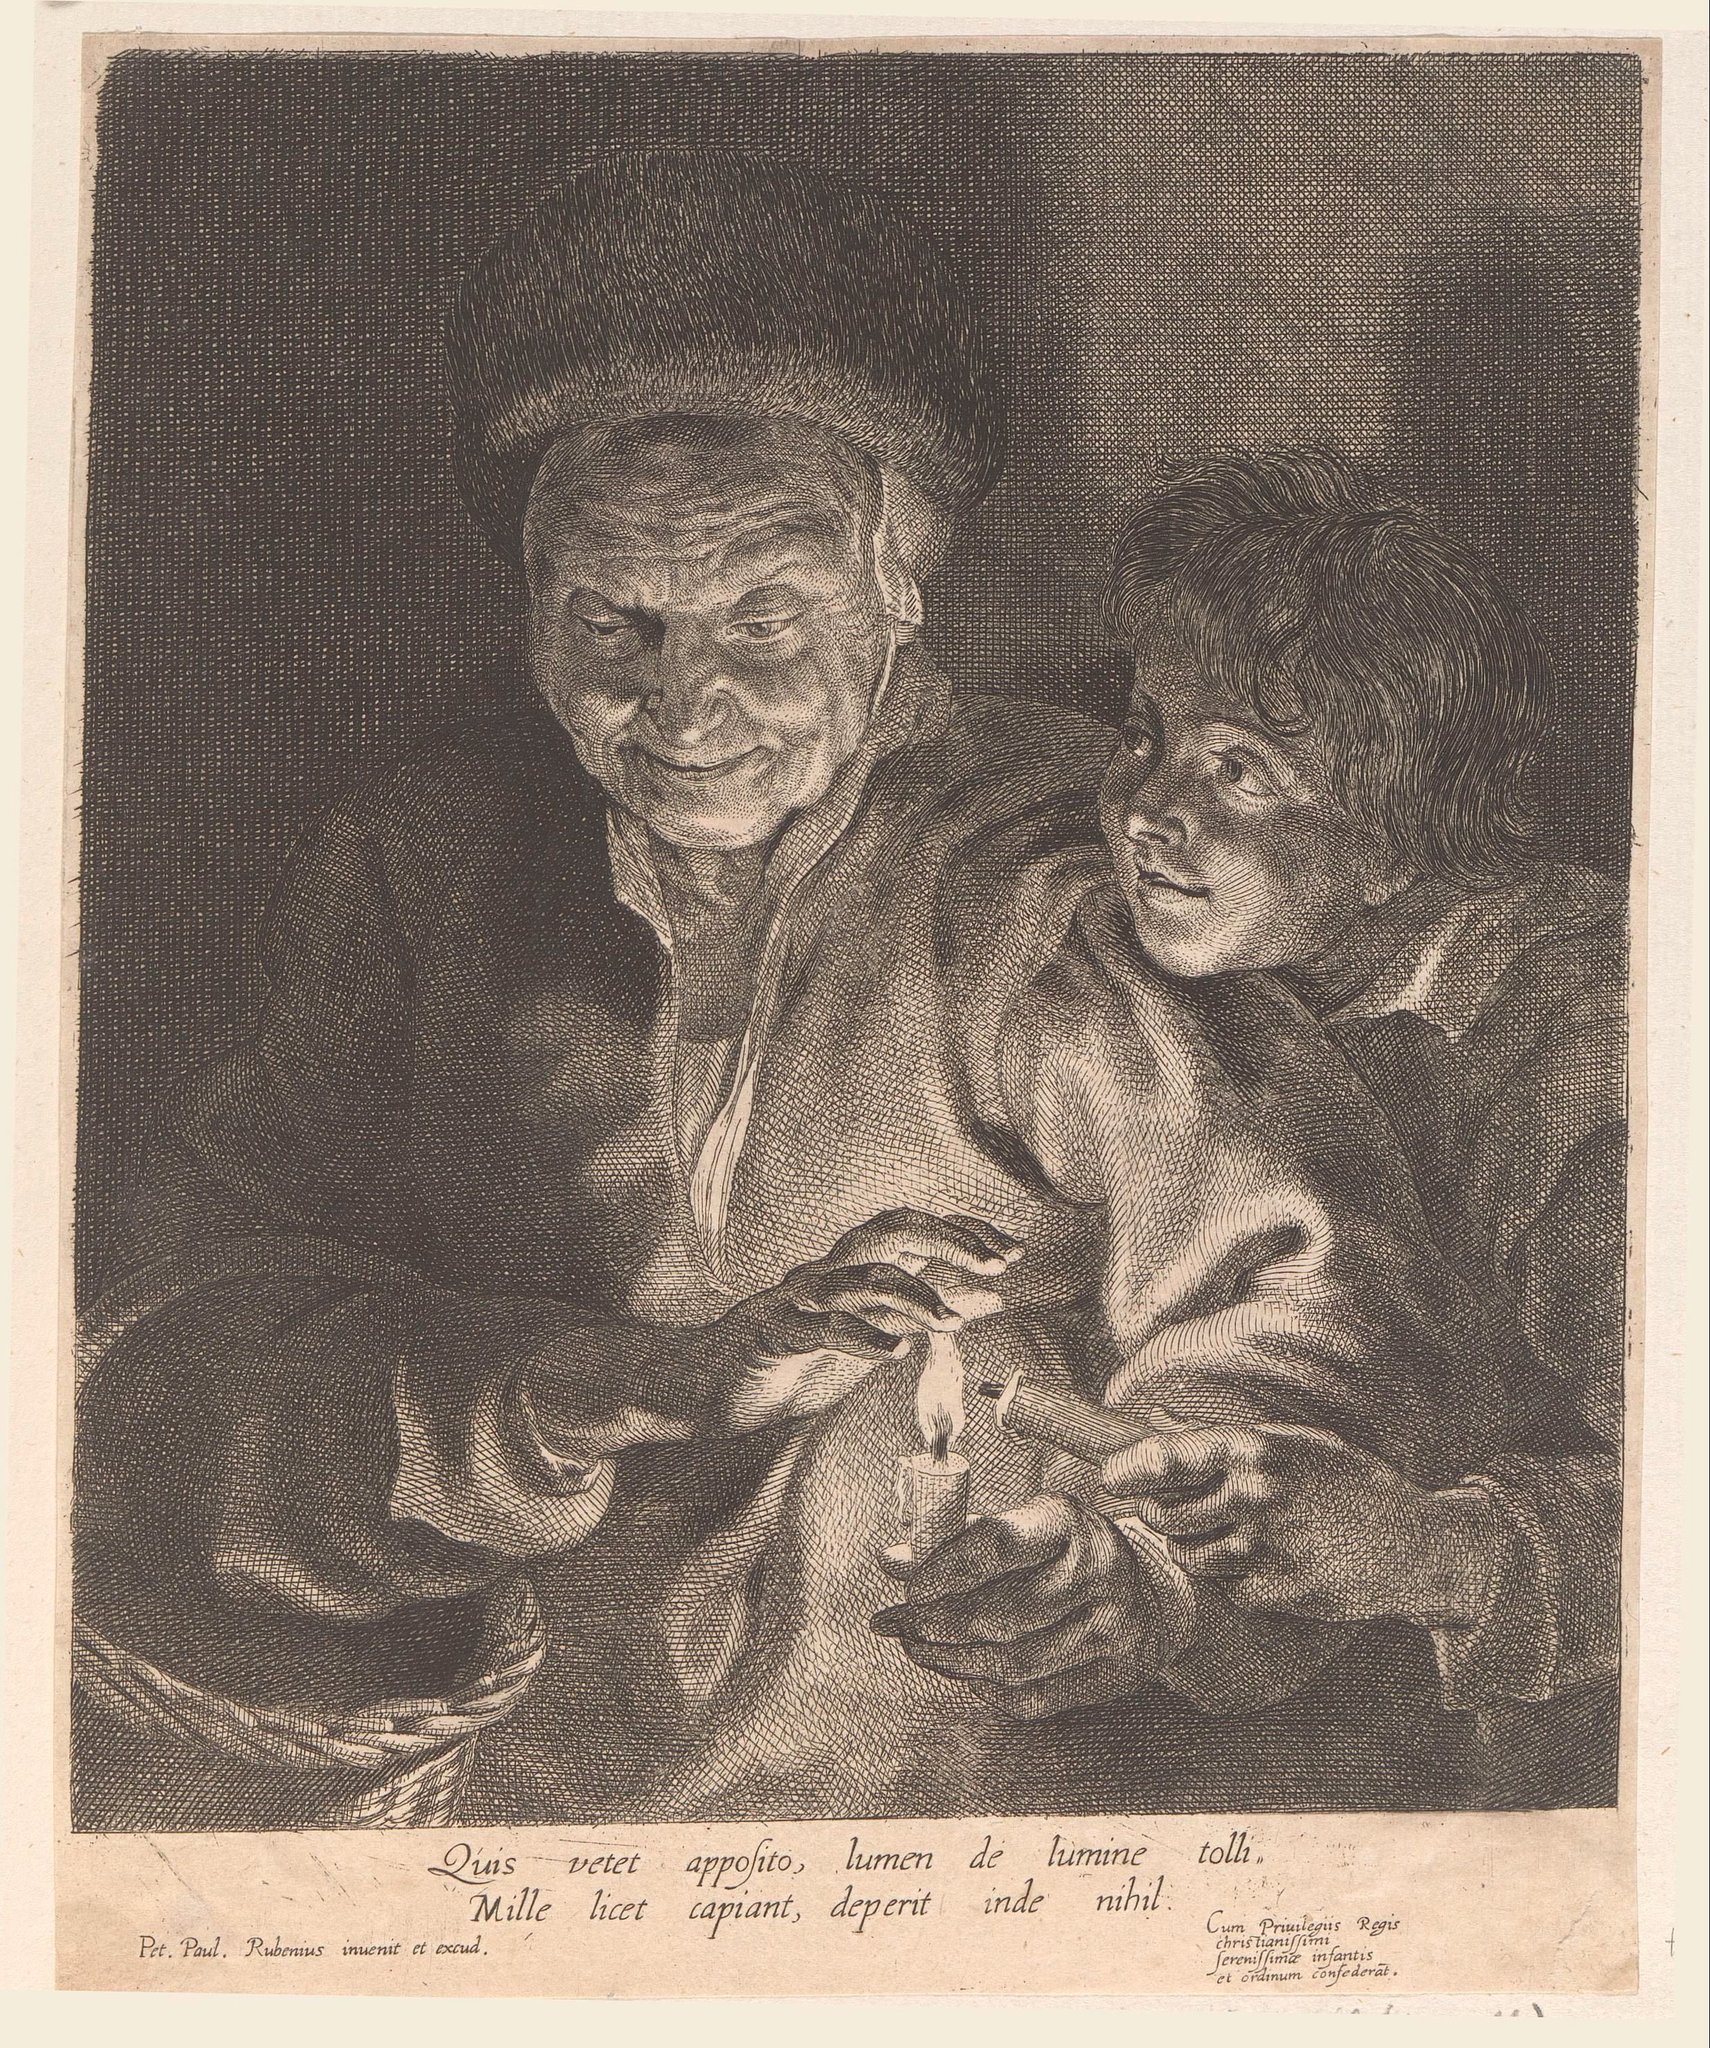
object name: album leaf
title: Oude vrouw en jongen met kaarsen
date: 1613-1658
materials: paper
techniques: engraving, etching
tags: scenes symbolizing 'vanitas', boy (child between toddler and youth), old woman, candle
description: Een jongen neemt met zijn kaars de vlam over van de kaars van de oude vrouw. In de marge een tweeregelig onderschrift in het Latijn. Deze prent maakt deel uit van een album.